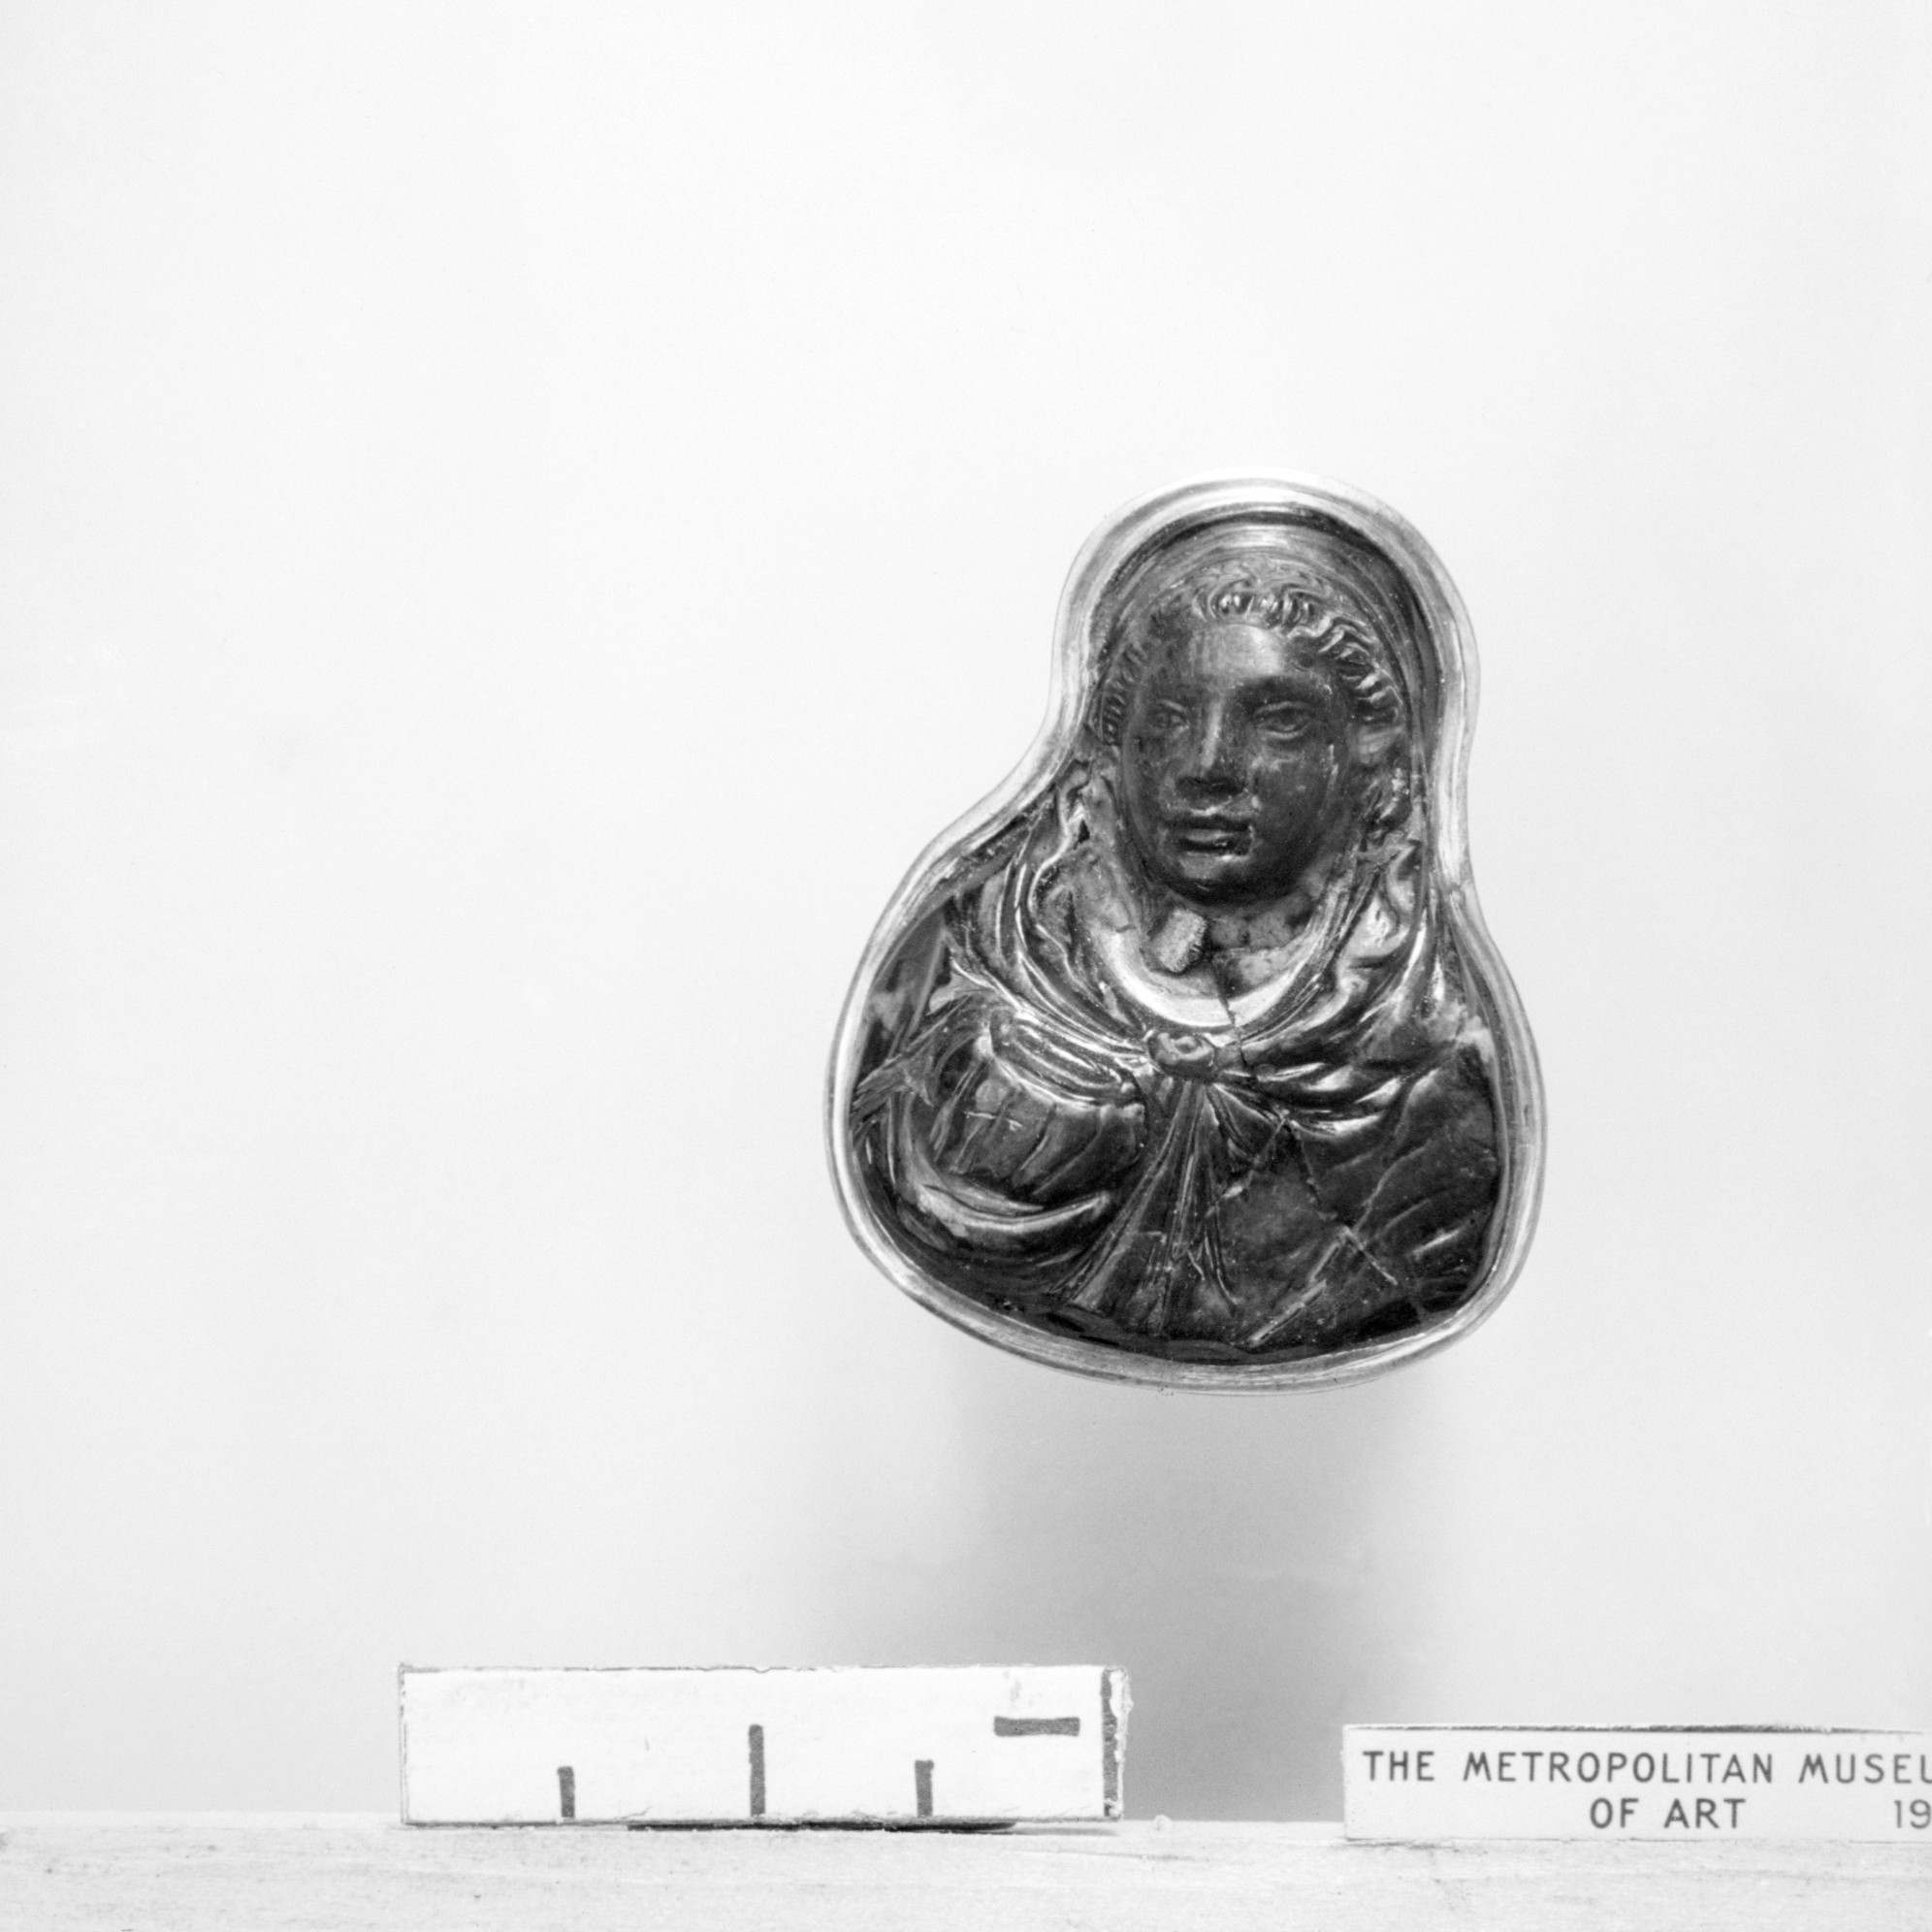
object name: cameo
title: Woman carrying a jar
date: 1501-1600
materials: stone, gold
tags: women